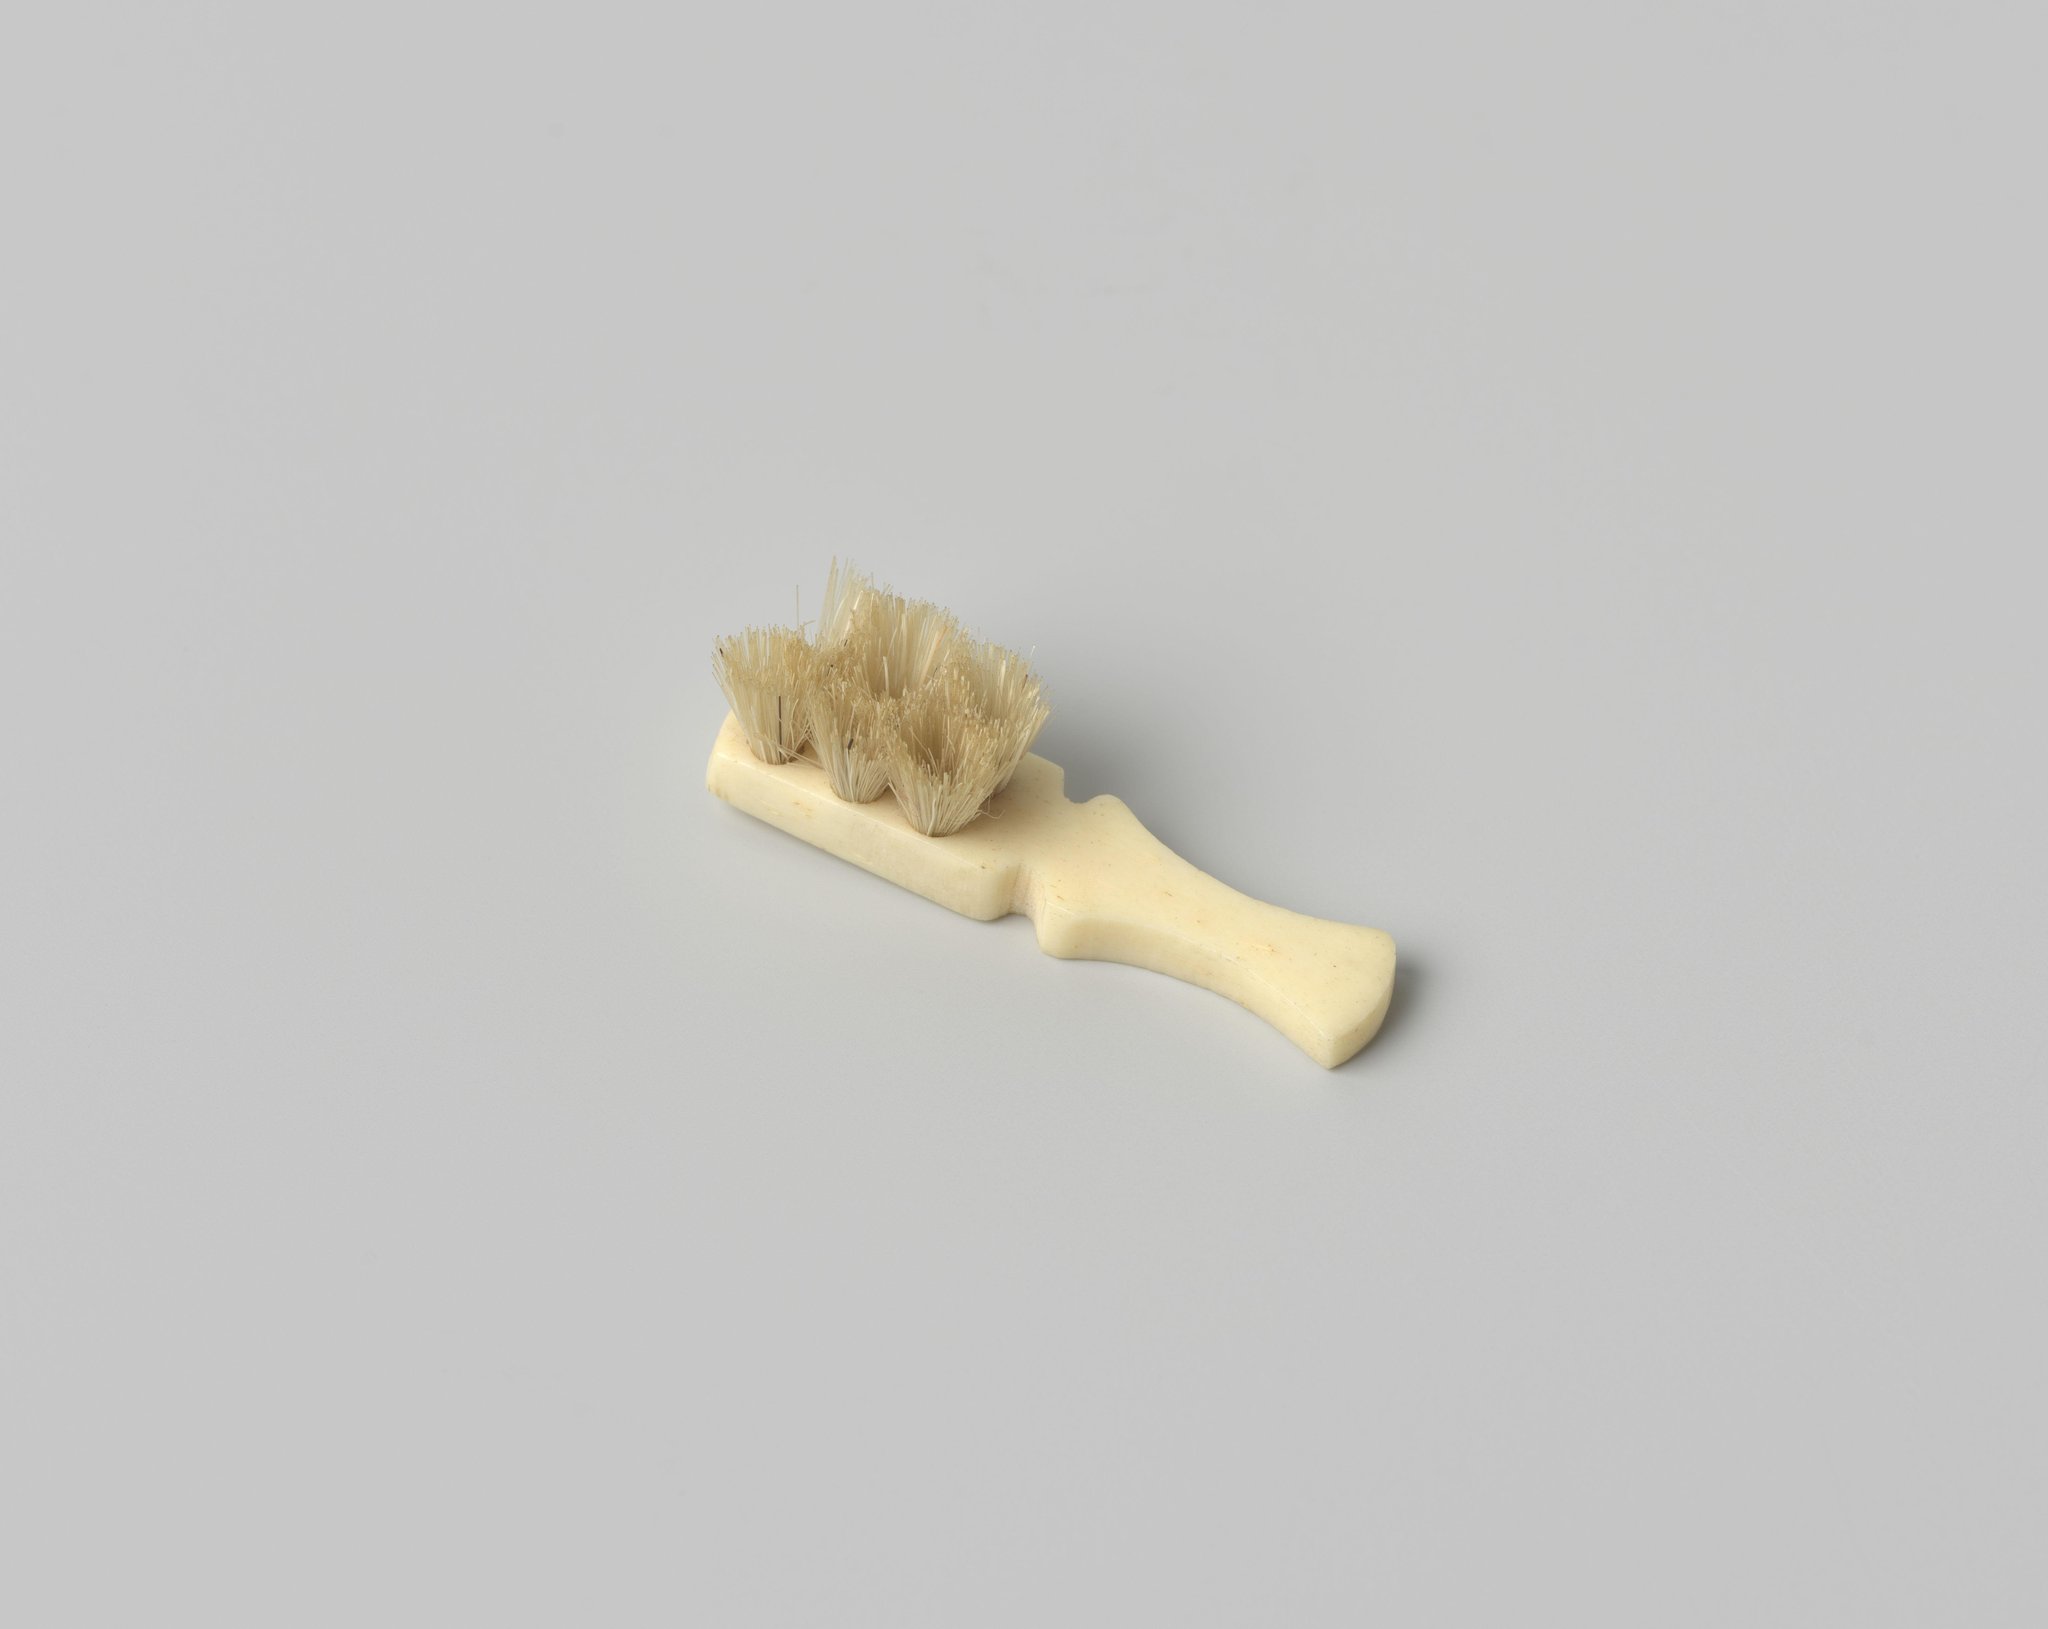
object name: brush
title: Borstel van ivoor en haar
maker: Anonymous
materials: hair, ivory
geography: netherlands